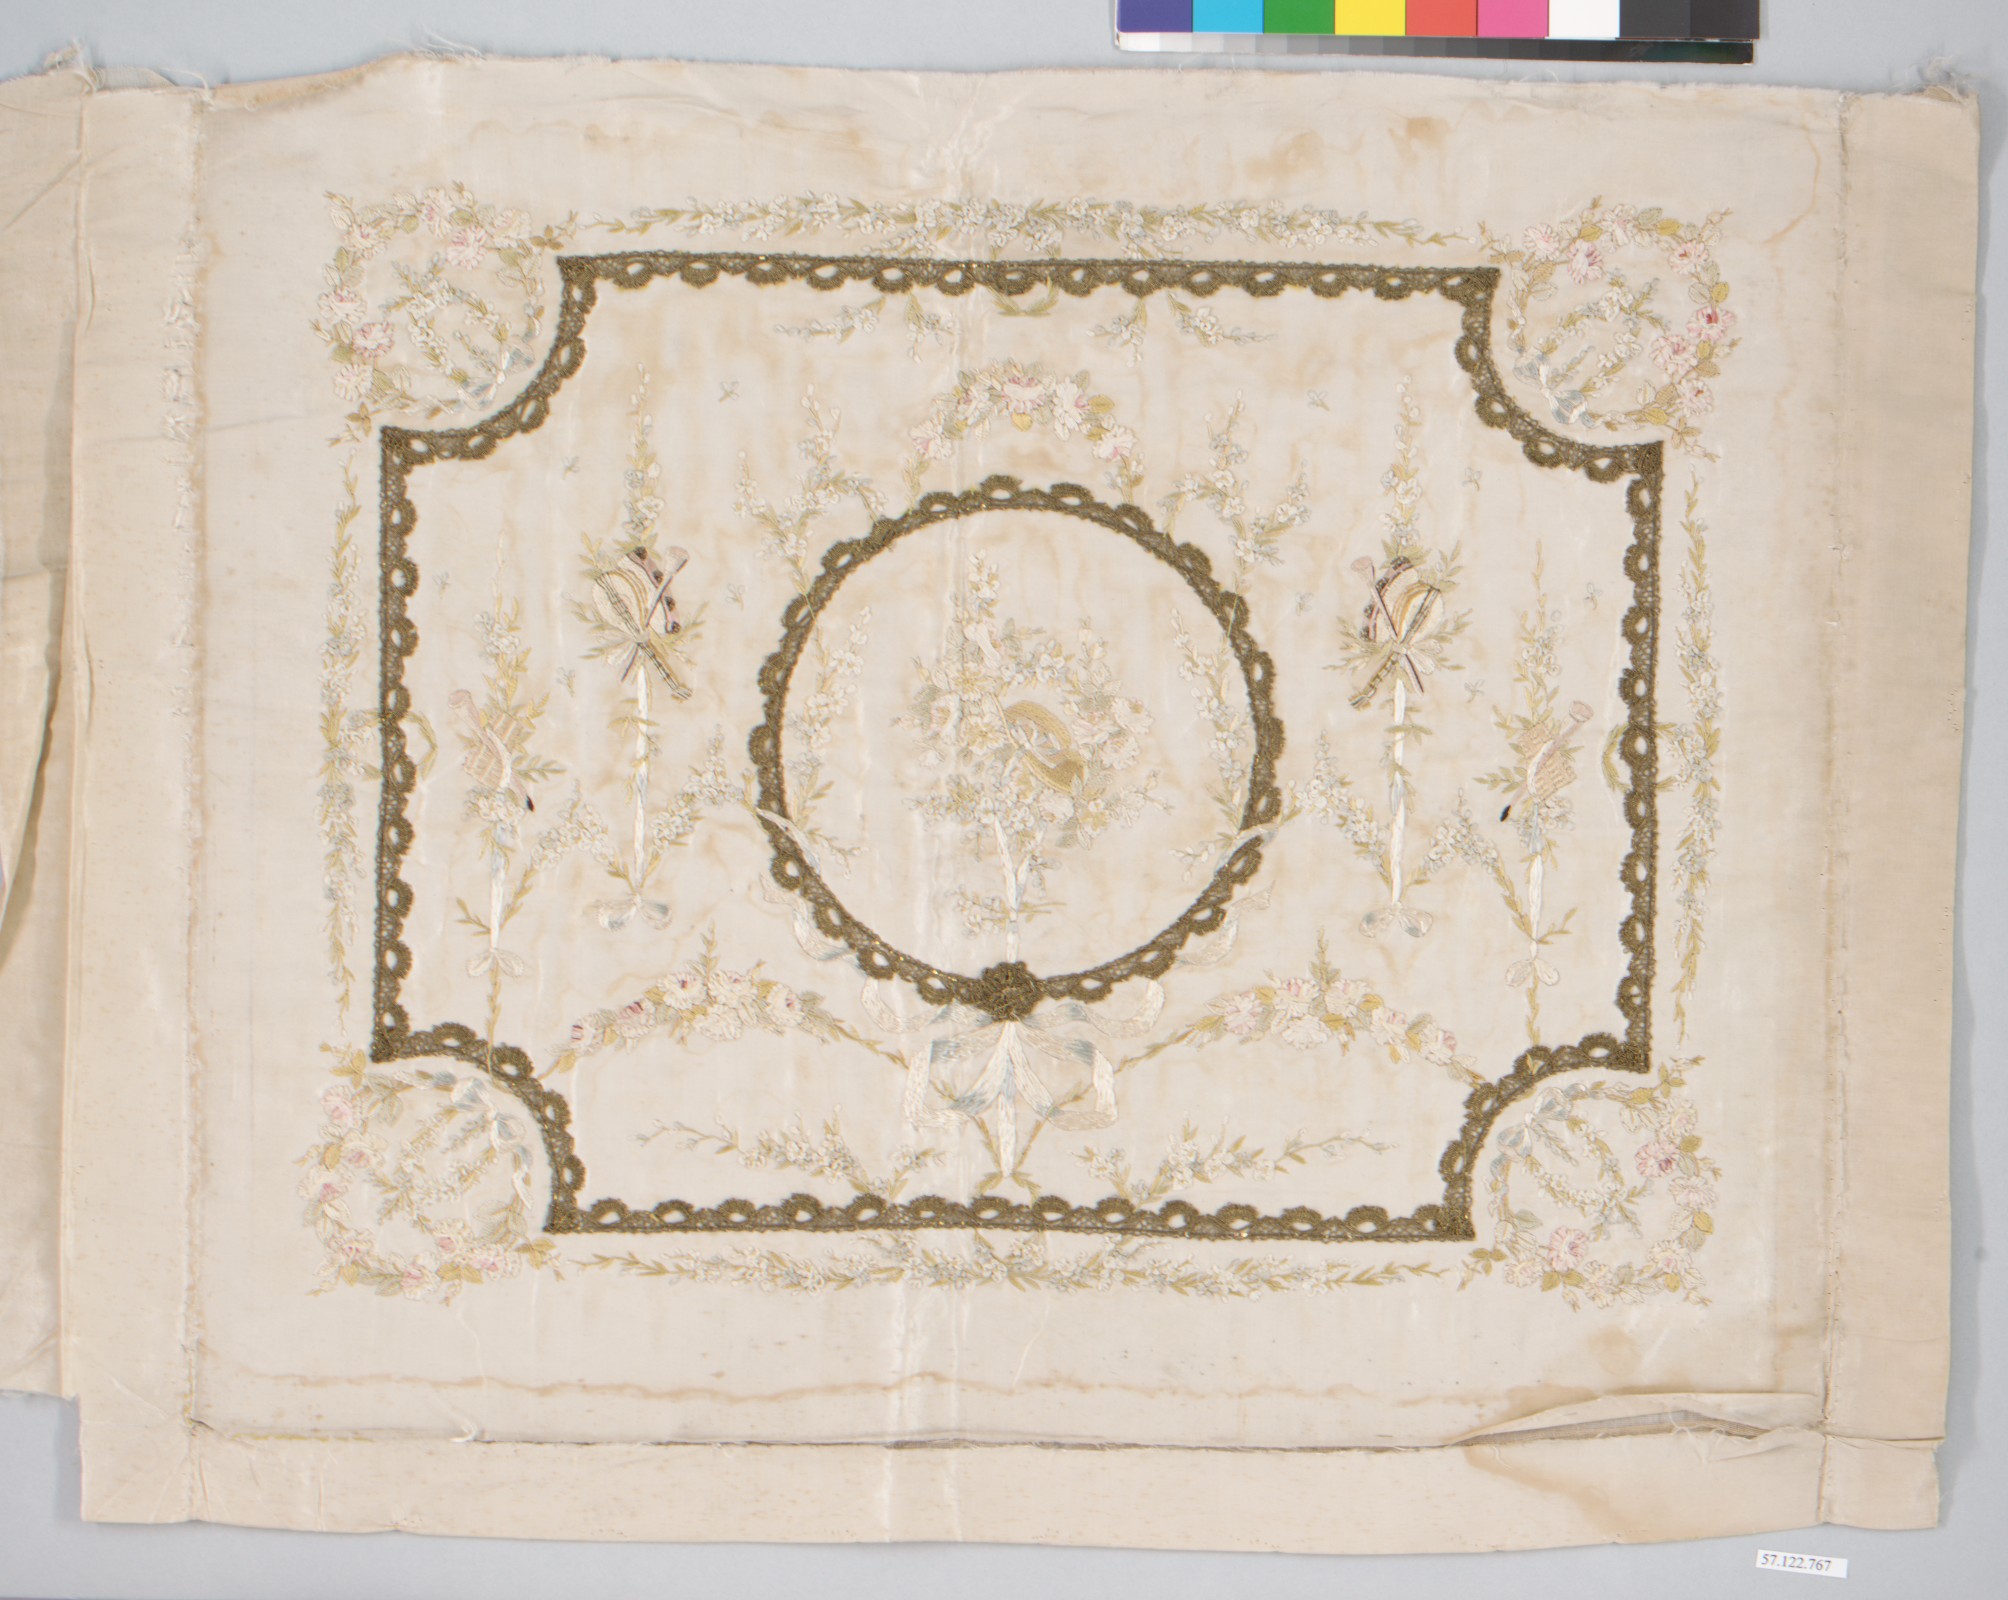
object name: cushion cover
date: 1801-1900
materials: lace, metal, metal thread, silk